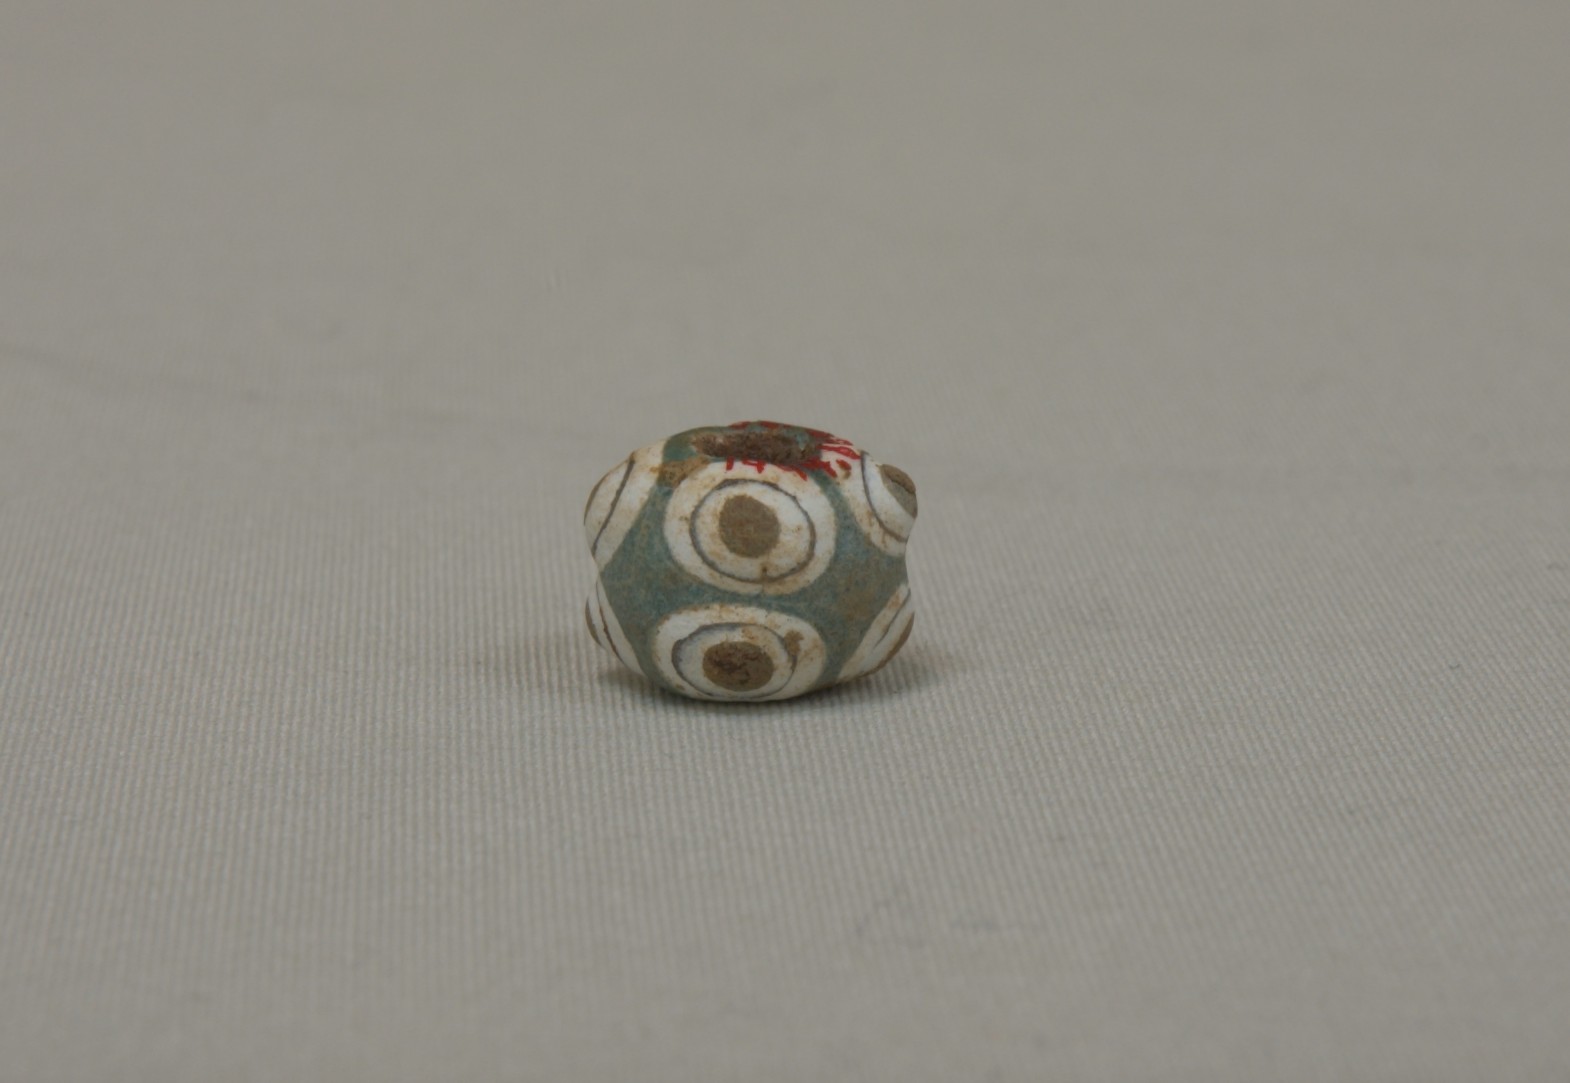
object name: bead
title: Eye Bead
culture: chinese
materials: glass